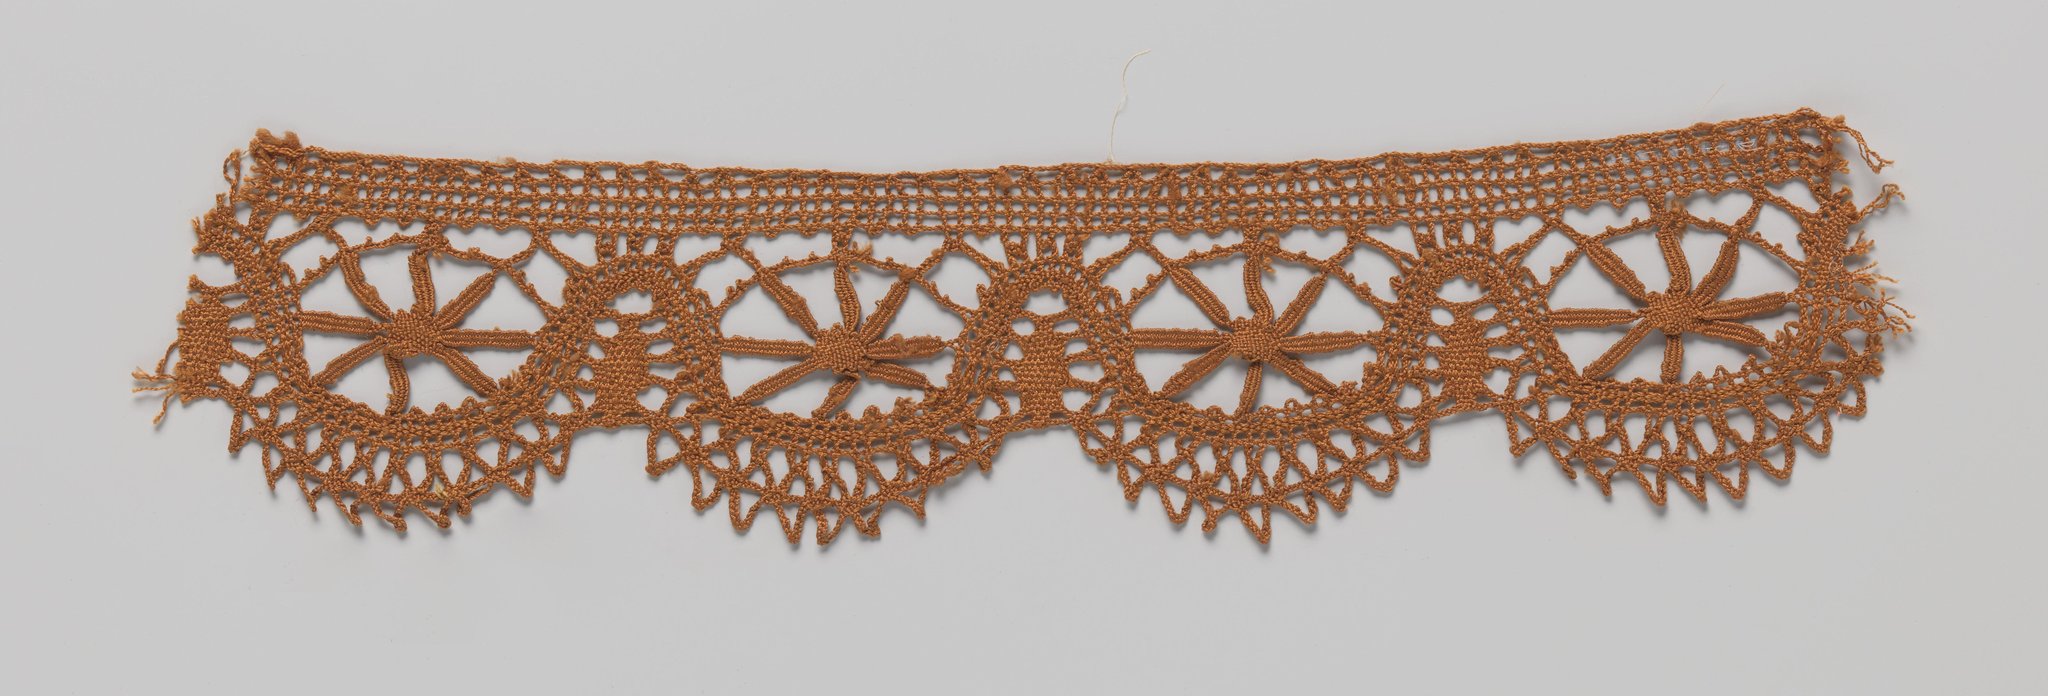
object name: strip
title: Strook bruine kloskant met wielen in halfronde schulpen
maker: Anonymous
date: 1870-1890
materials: silk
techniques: lace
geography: le puy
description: Strook bruin kloskant: Cluny-kant. Het zich herhalende patroon bestaat uit wielen in een golvende schulpenrand met halfronde schulpen. De spaken van de wielen zijn gemaakt in vormslag rond een centrum in linnenslag. De bovenzijde van de strook is recht afgewerkt.